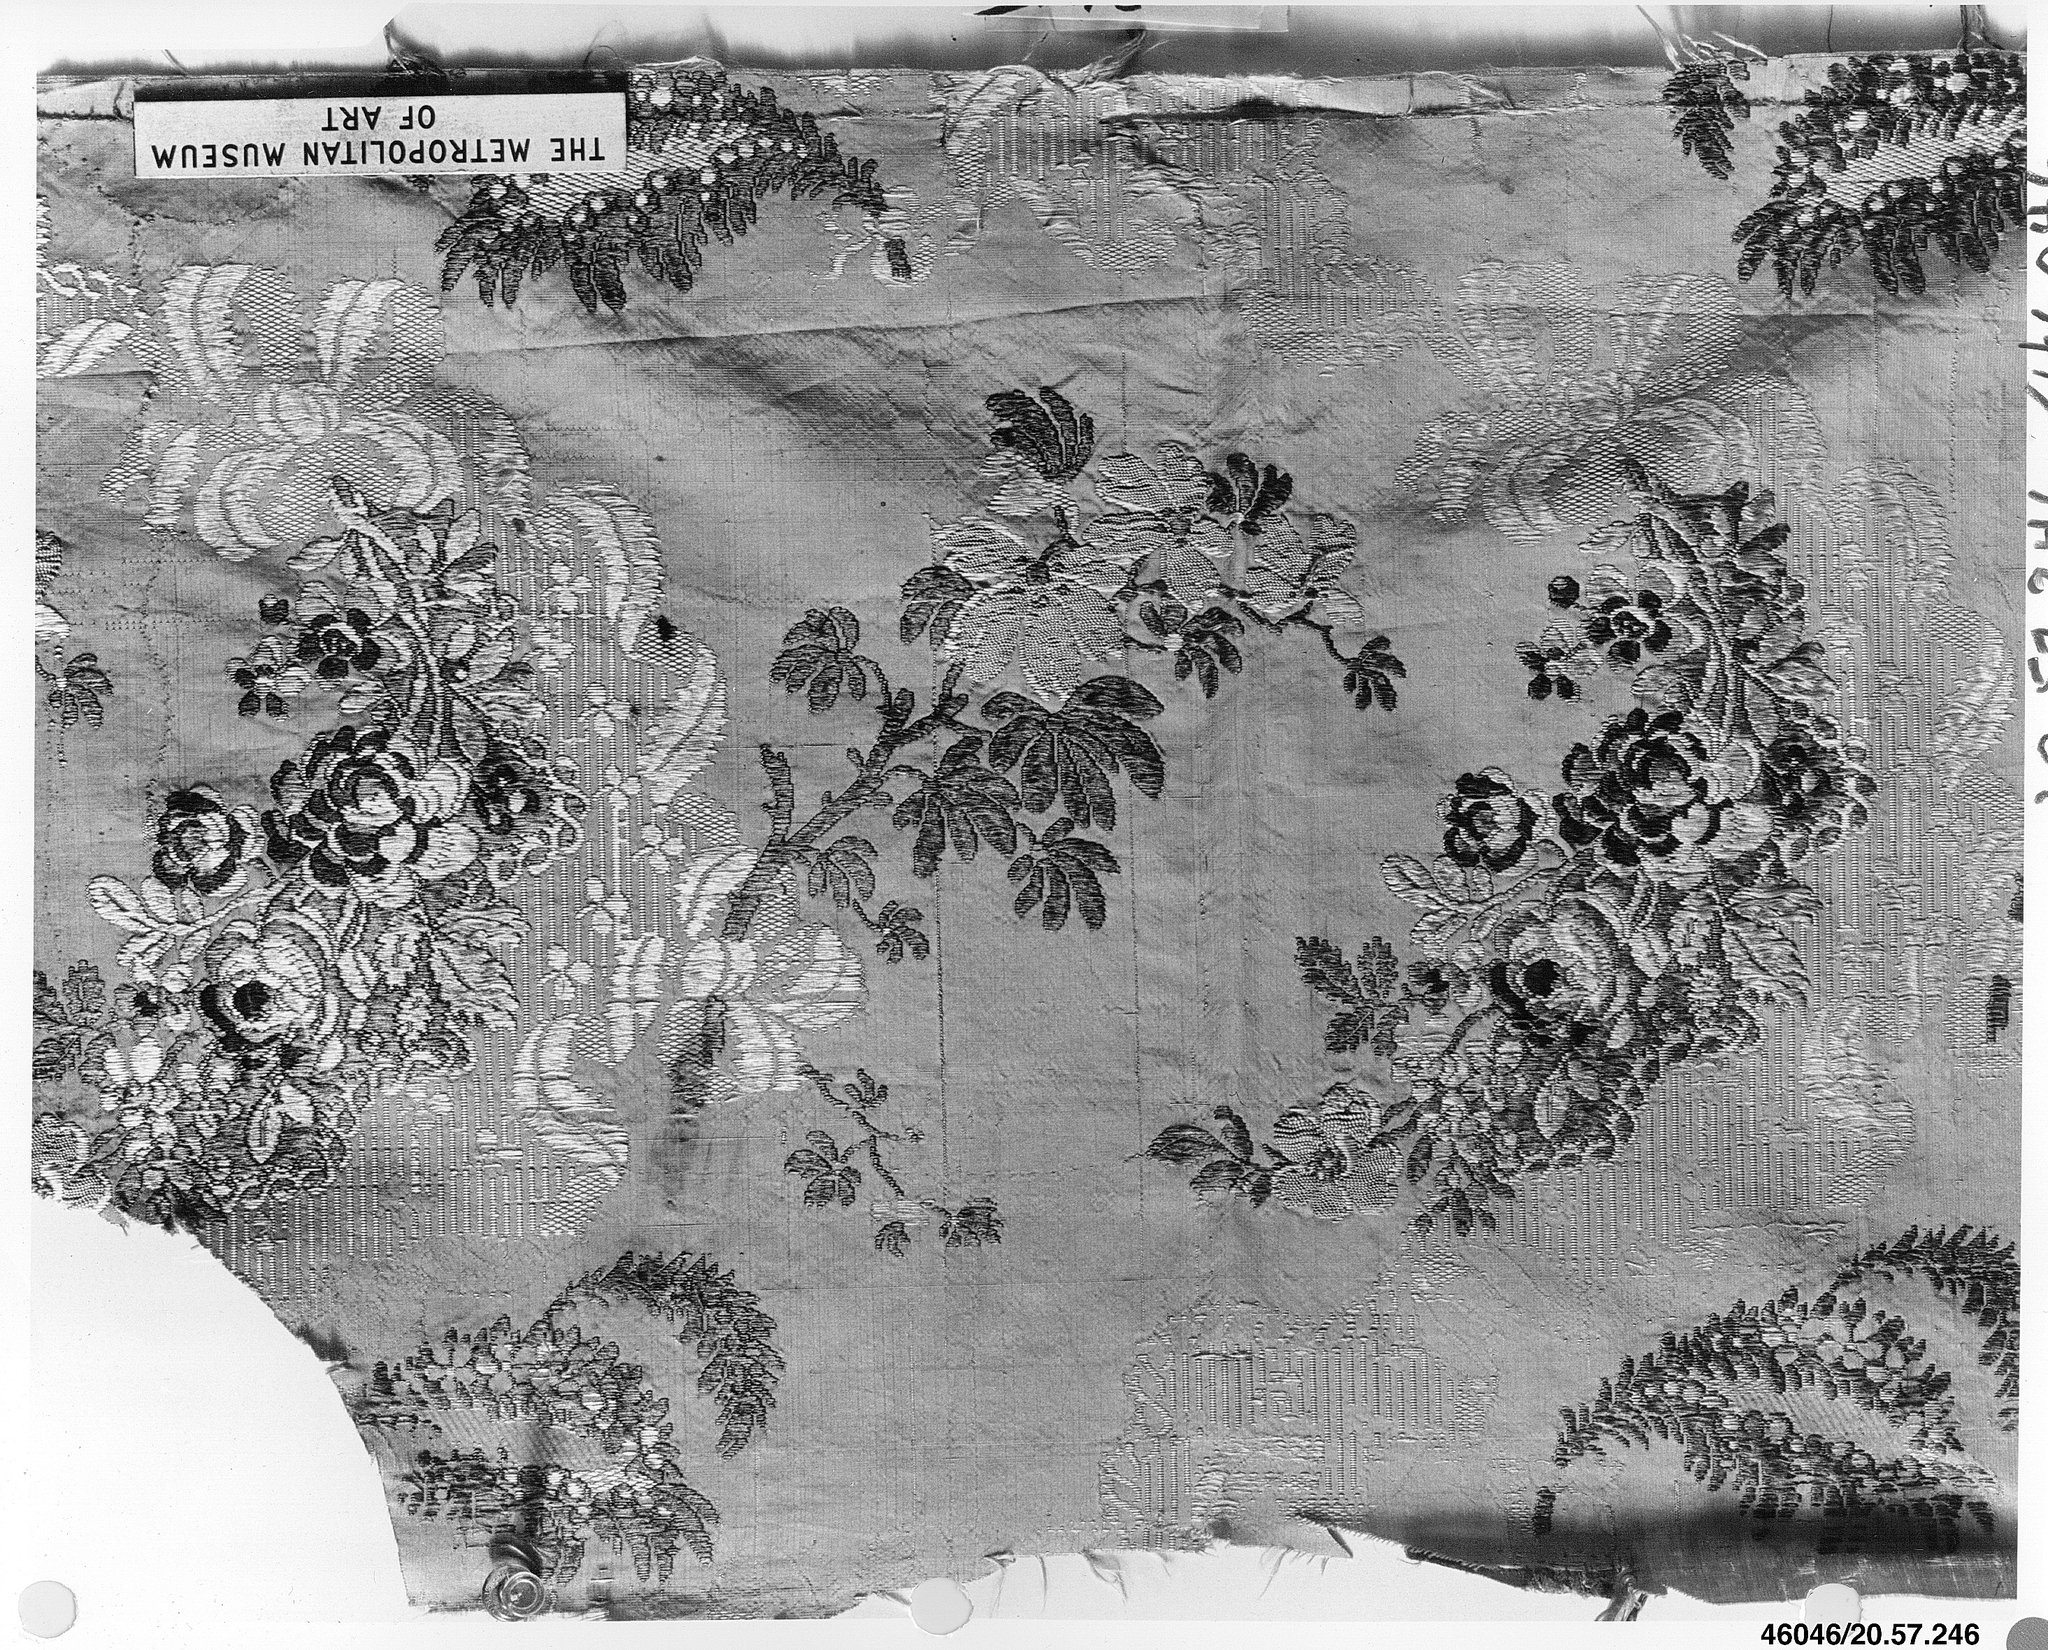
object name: piece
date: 1750-1760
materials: silk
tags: flowers,leaves